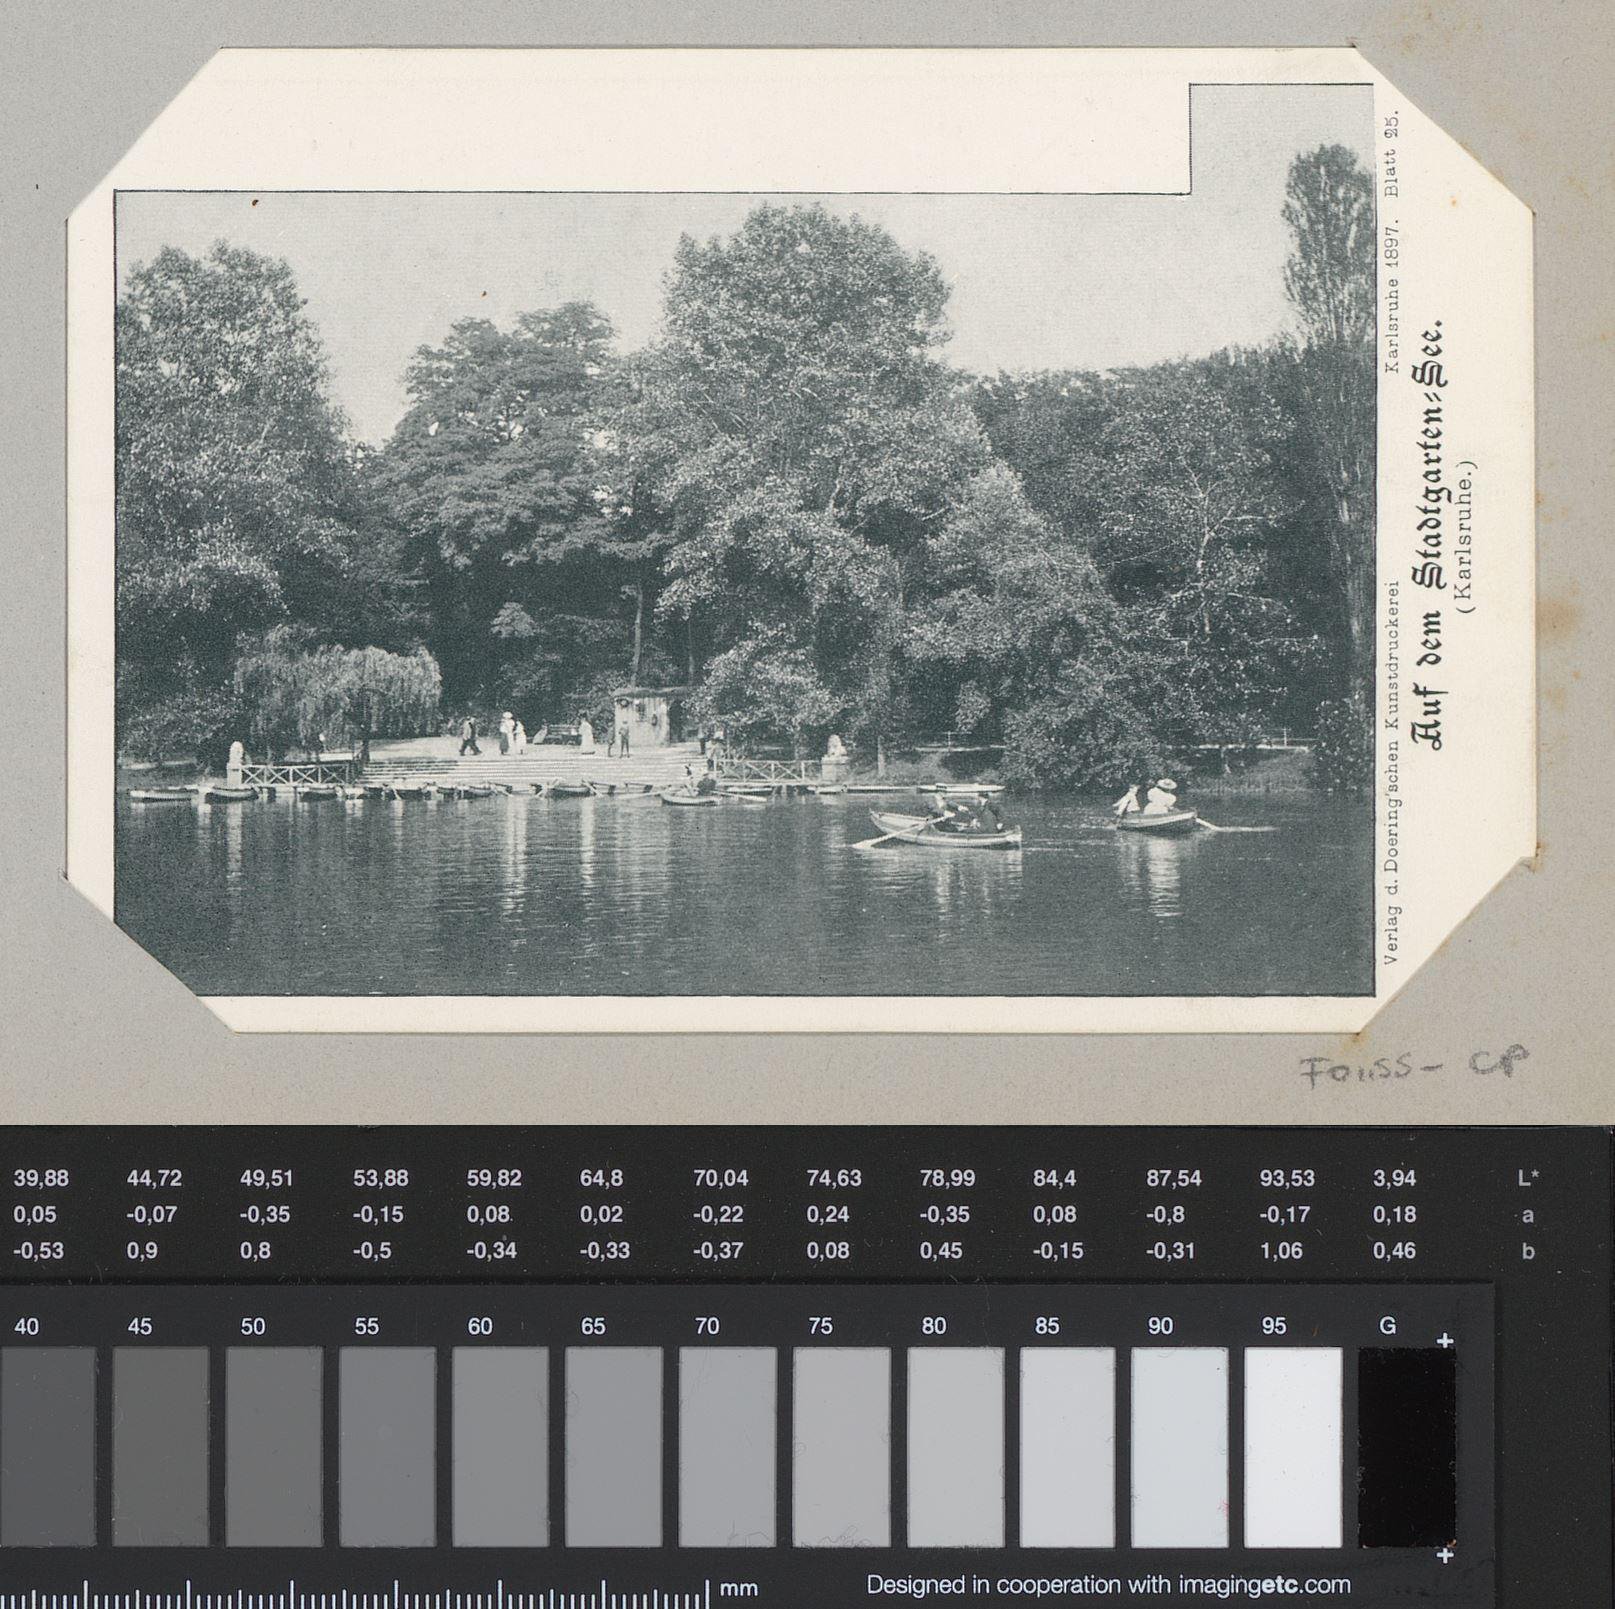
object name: album leaf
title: Gezicht op een stadsvijver moet roeiboten te Karlsruhe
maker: Anonymous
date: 1897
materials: paper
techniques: autotype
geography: karlsruhe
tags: public gardens, park (+ city(-scape) with figures, staffage), rowing-boat, canoe, etc.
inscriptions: inscription: ‘Verlag d. Doering'schen Kunstdruckerei/ Karlsruhe 1897. Blatt 25./ Auf dem Stadtgarten-See./ (Karlsruhe)’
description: Deze prent maakt deel uit van een album.